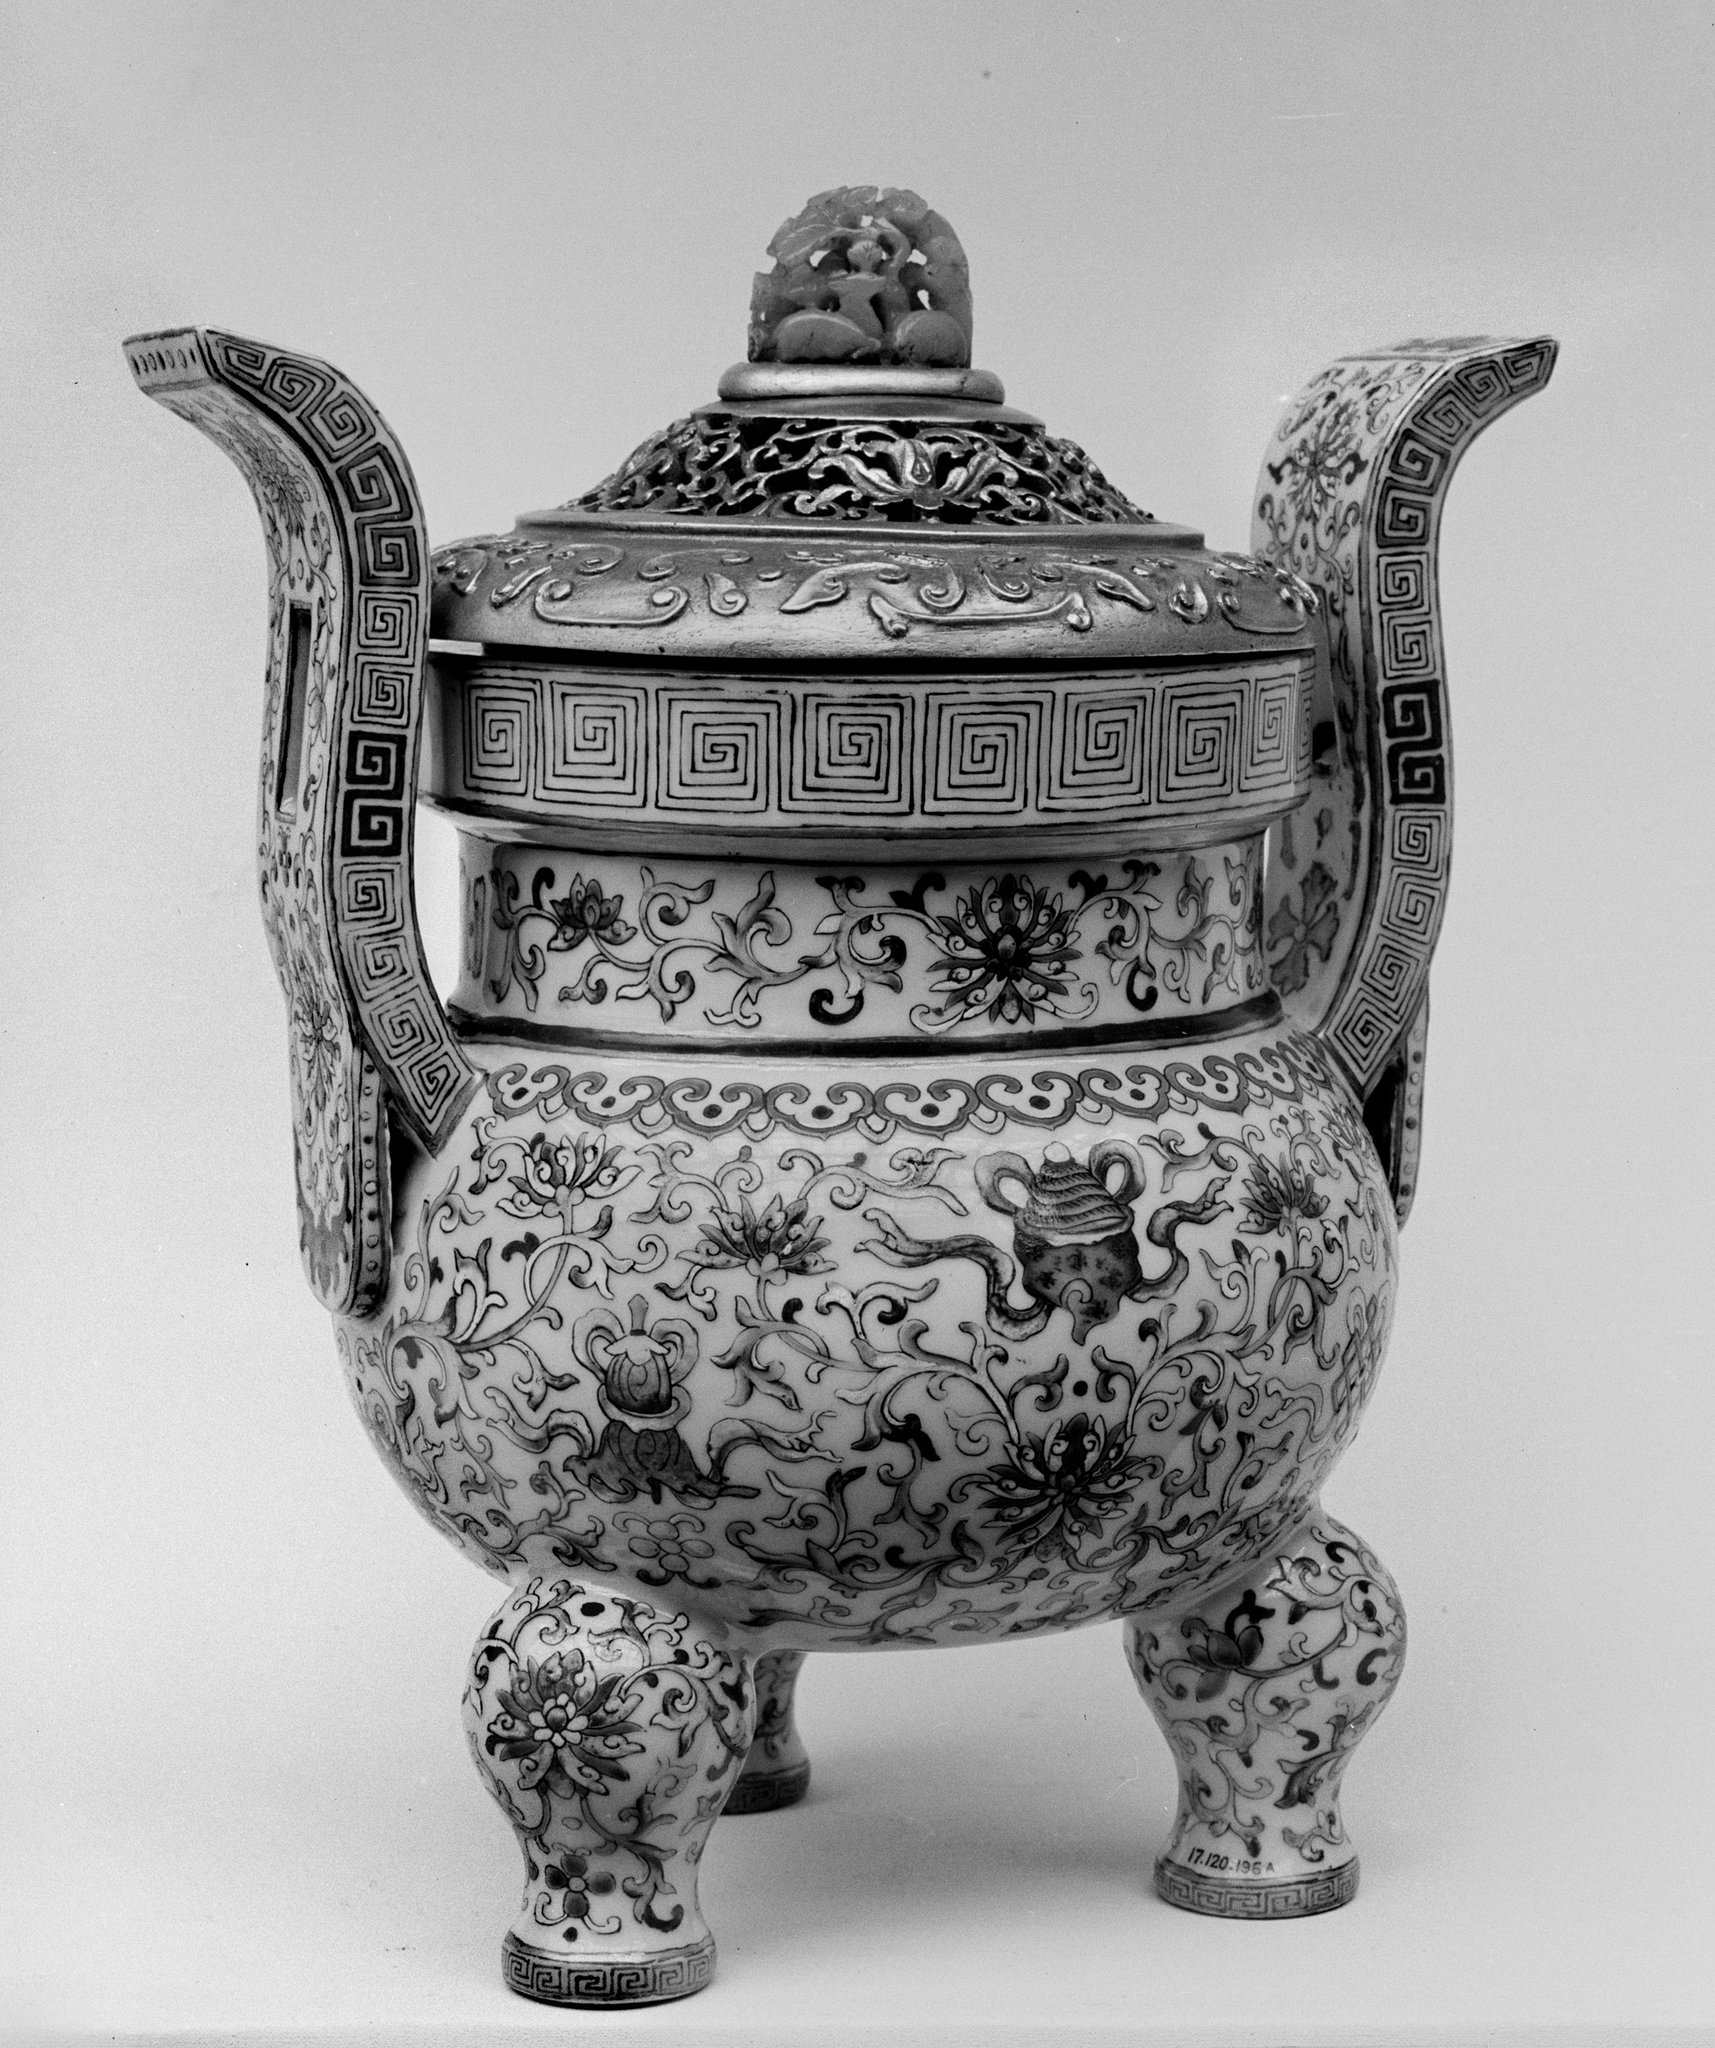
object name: incense burner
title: Tripod incense burner with Buddhist auspicious symbols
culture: chinese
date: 1767-1833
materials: enamel, jade, porcelain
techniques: overglaze, painting, polychrome